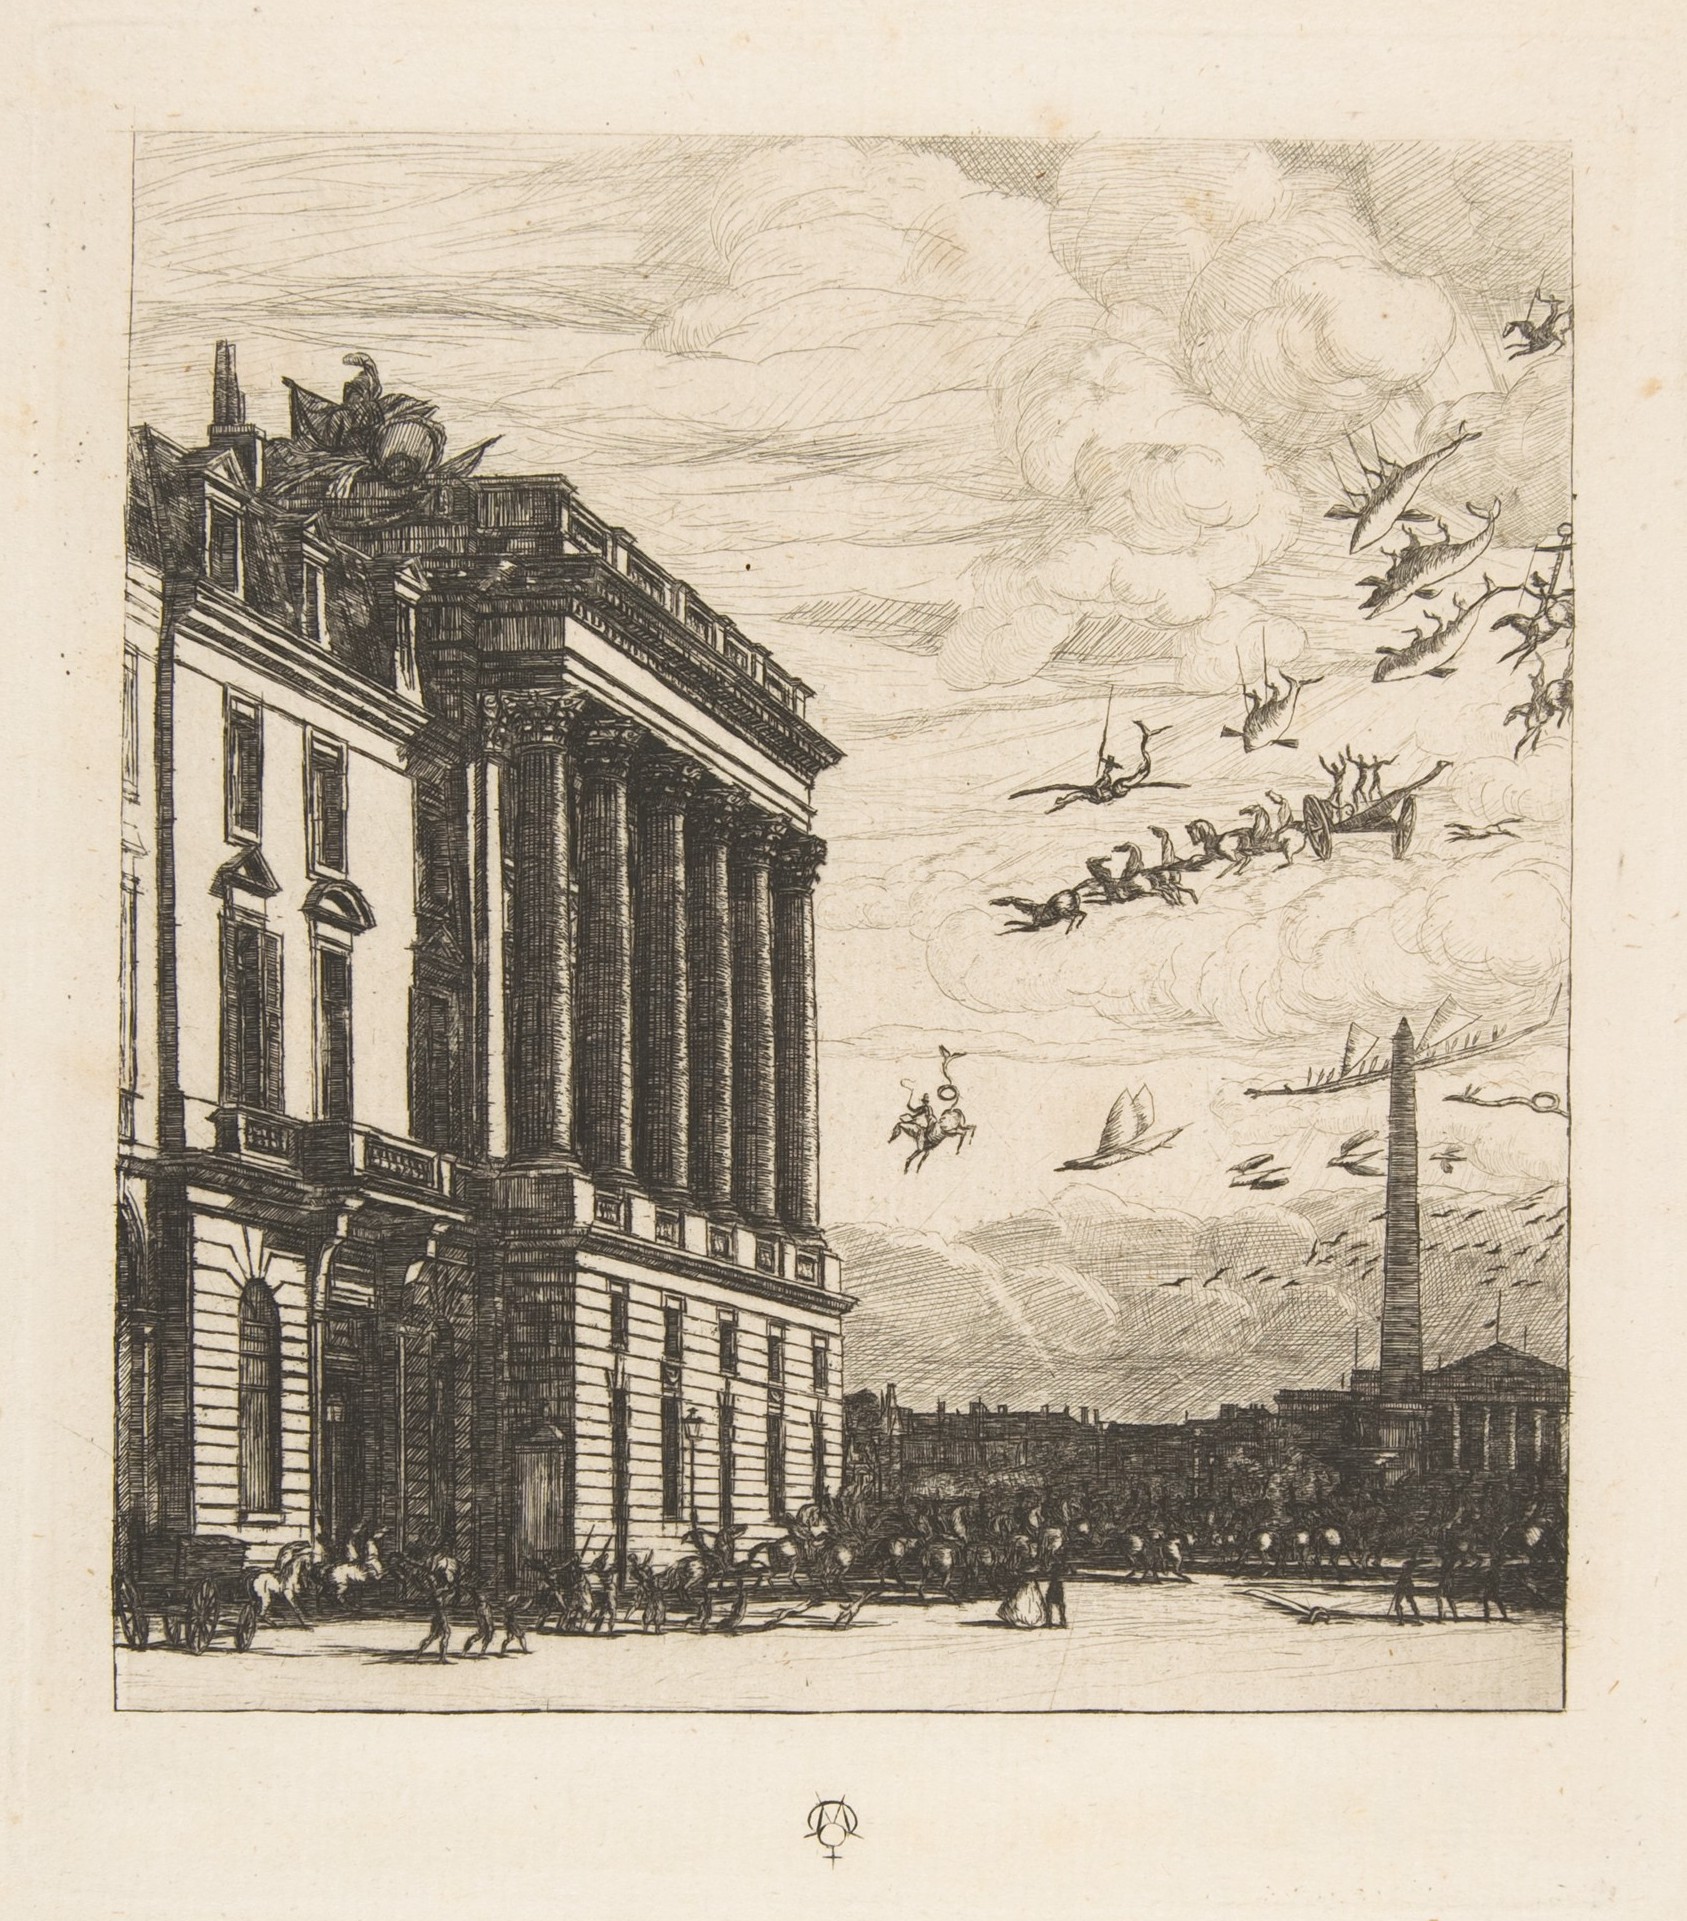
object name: print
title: Le Ministere de la Marine (The Admiralty, Paris)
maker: charles meryon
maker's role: artist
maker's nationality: french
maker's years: 1821-1868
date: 1865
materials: paper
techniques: etching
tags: buildings,paris